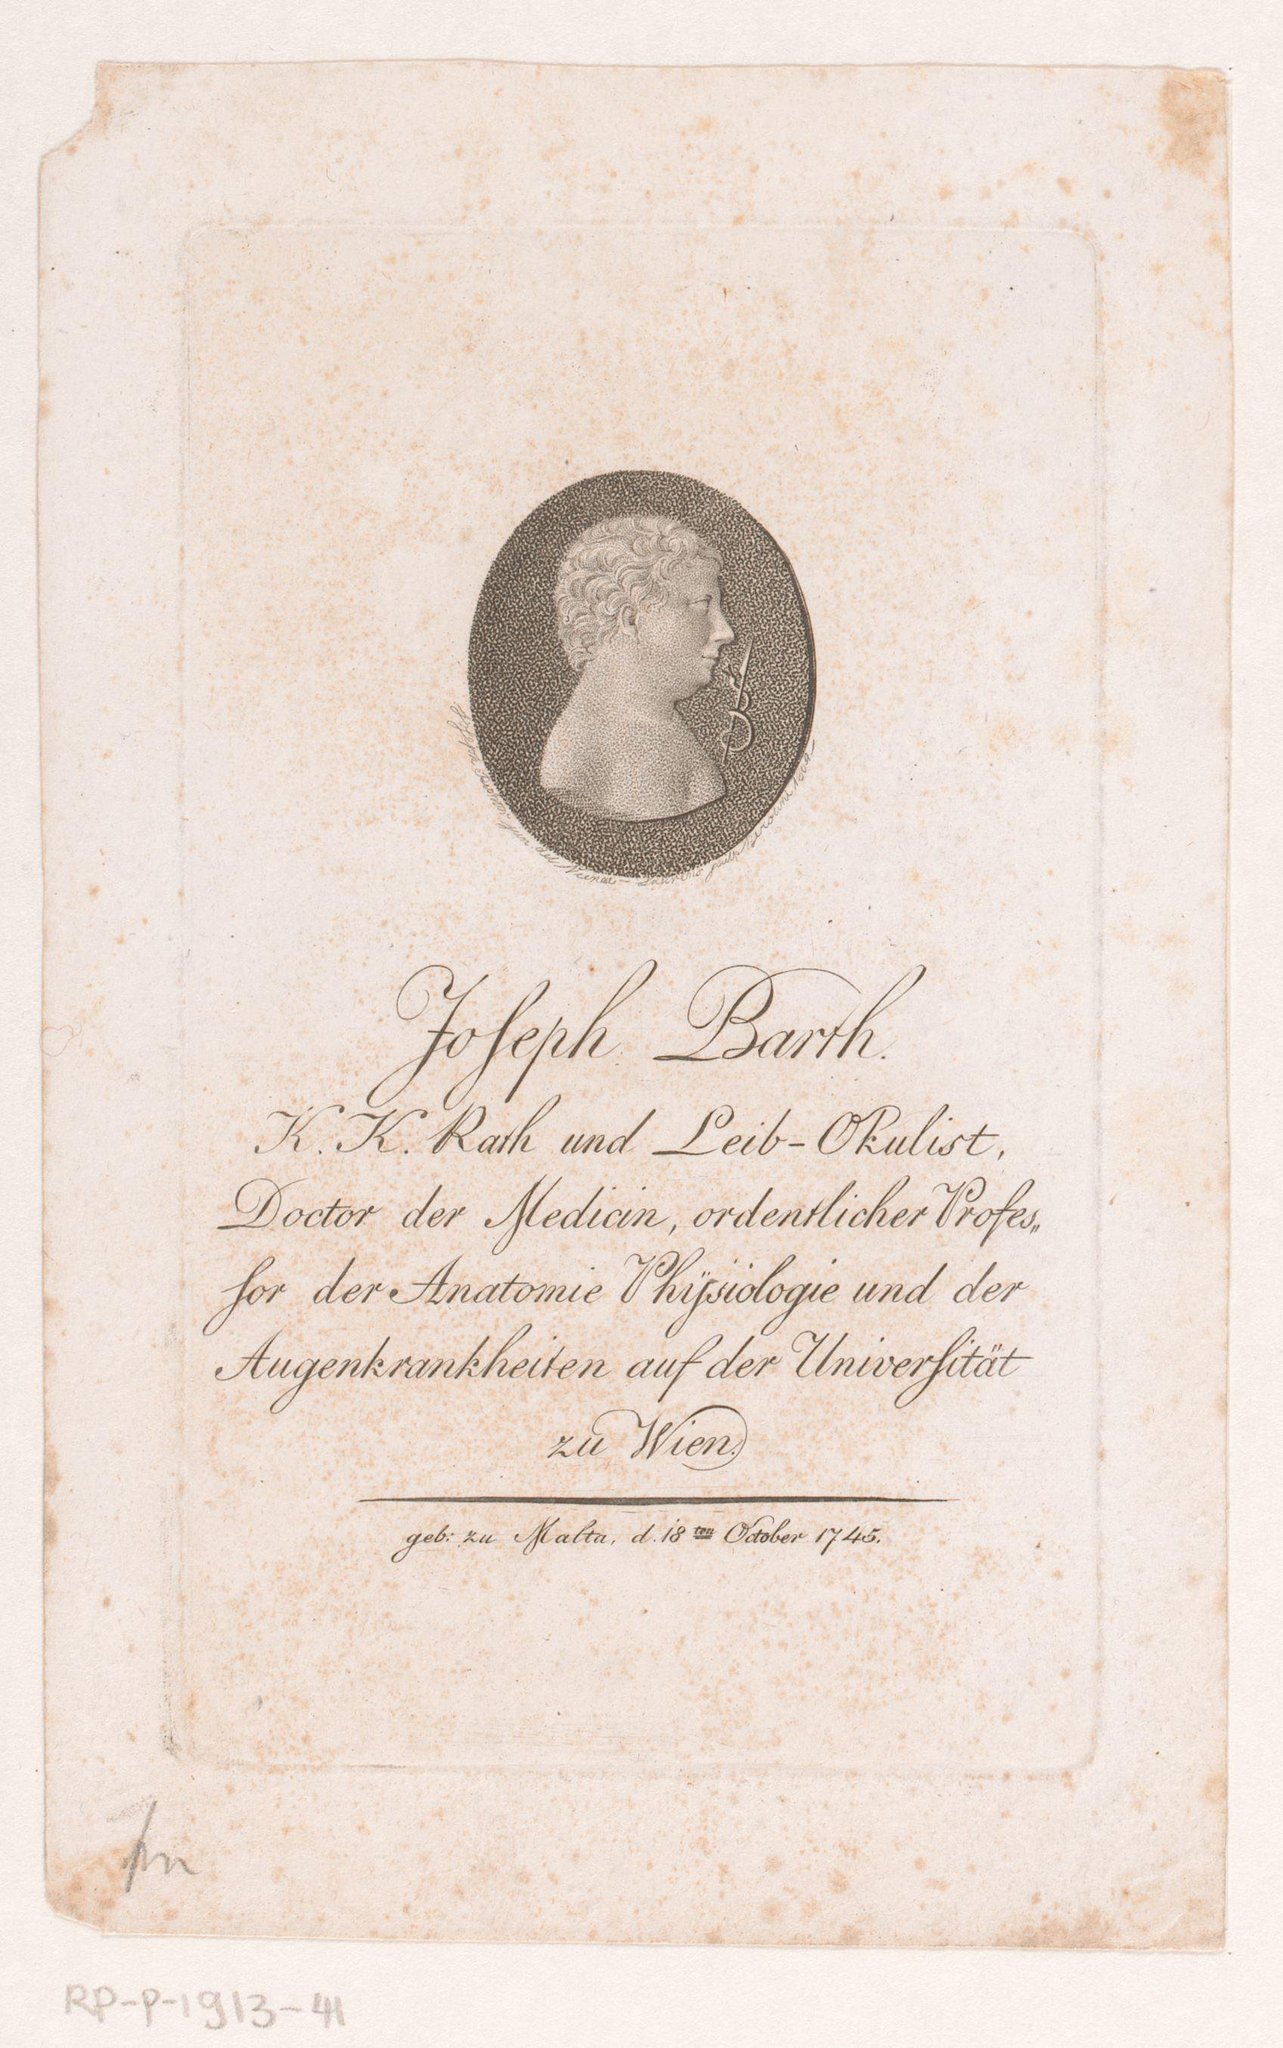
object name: print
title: Portret van Joseph Barth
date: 1802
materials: paper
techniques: stippling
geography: berlin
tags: further education (+ portrait of teacher, professor), historical persons, physician, doctor (+ portrait of scholar, scientist), caduceus (staff with two snakes, attribute of mercury)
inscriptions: collector's mark: Lugt 2228